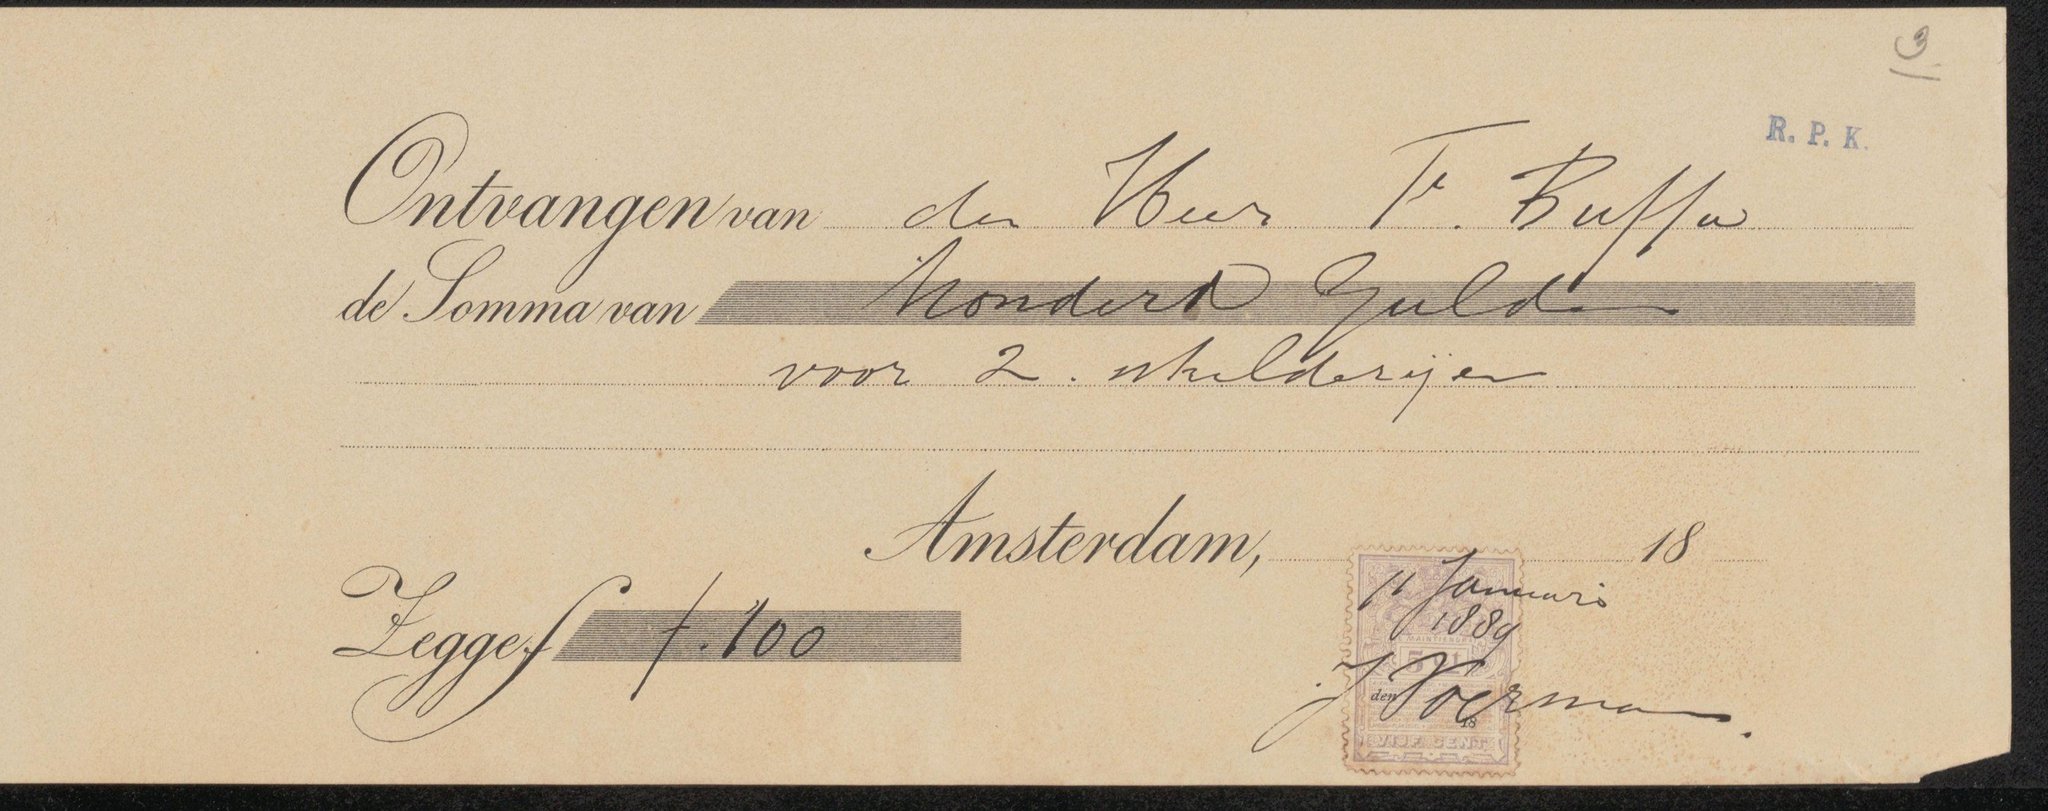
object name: ontvangstbewijs, kwitantie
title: Kwitantie voor Jan Voerman (1857-1941)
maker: jan voerman (1857-1941)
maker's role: draughtsman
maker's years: 1857-1941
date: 1889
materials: ink, paper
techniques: pen, printing, writing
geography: amsterdam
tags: painting (including book-illumination, miniature-painting), money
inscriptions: collector's mark: Lugt 2233